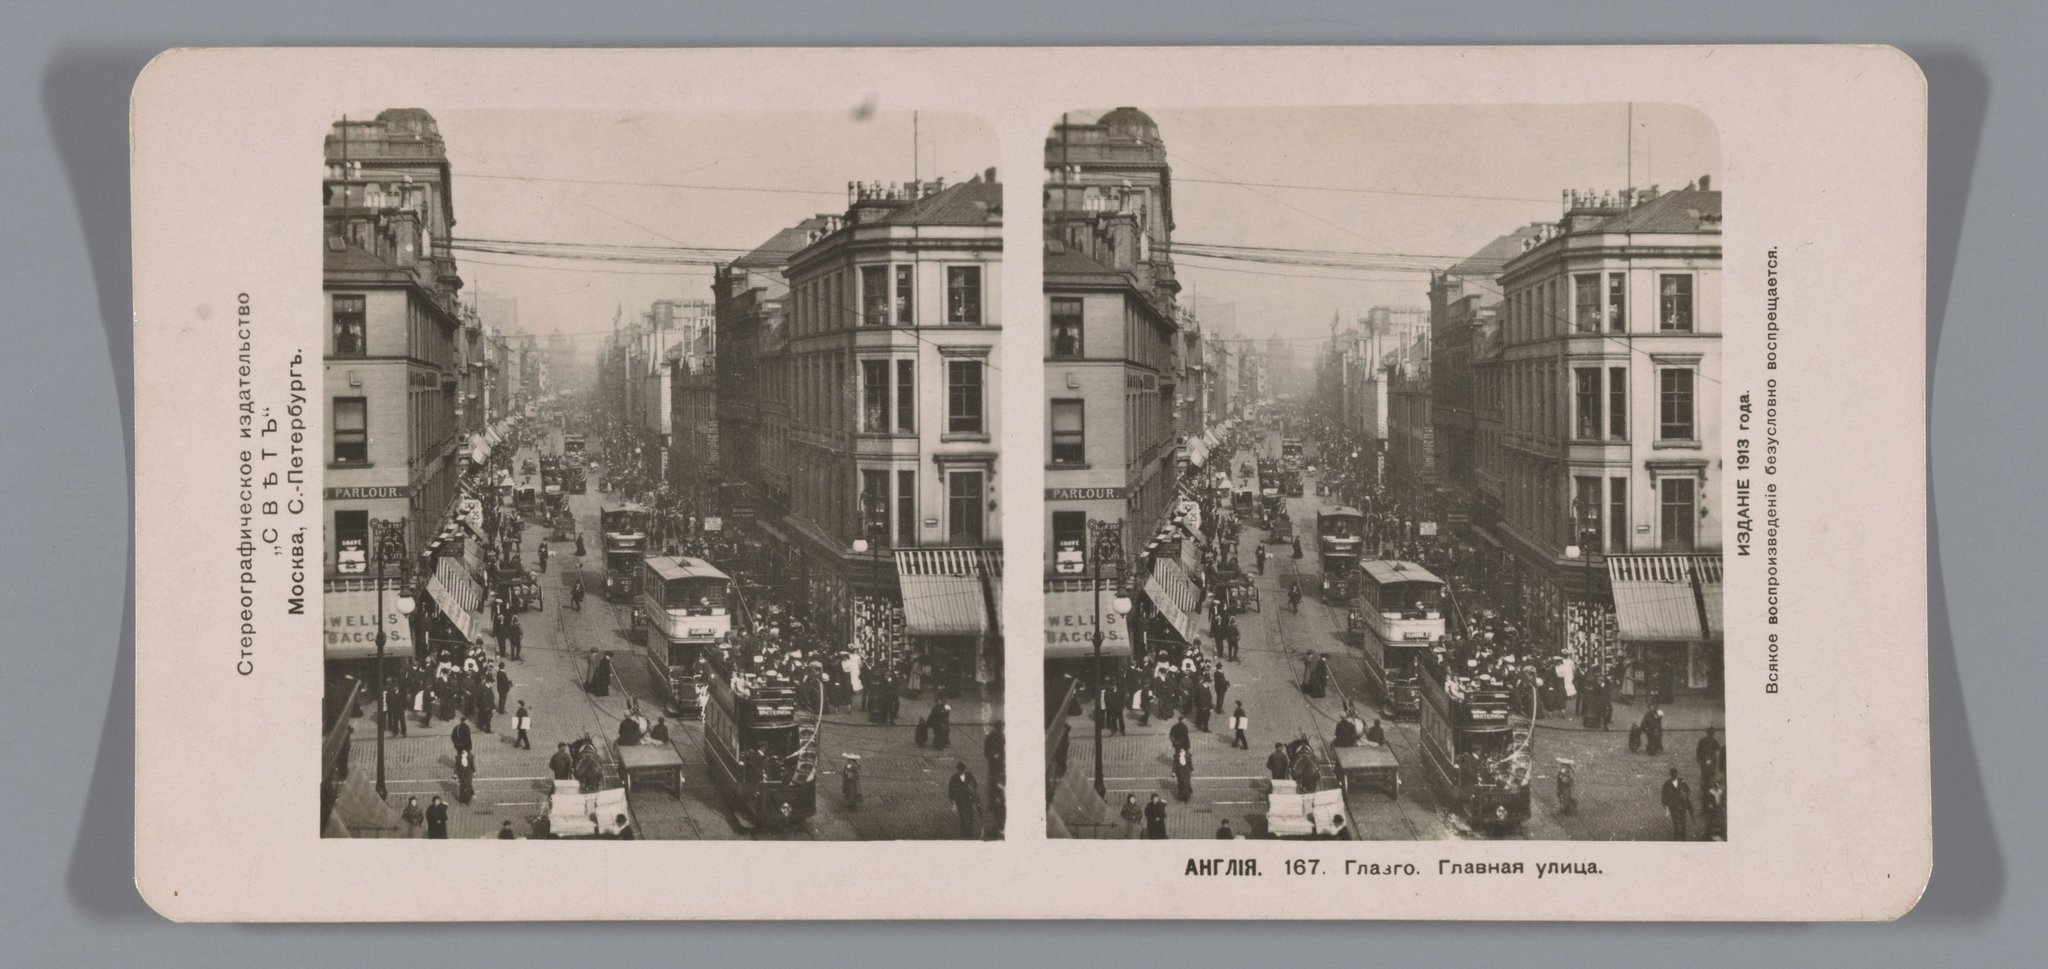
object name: stereograph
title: Gezicht op een straat te Glasgow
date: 1913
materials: cardboard, photographic support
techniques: gelatin silver print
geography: glasgow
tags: street, glasgow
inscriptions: inscription: ‘Izdanie 1913 gora, wsjakoje wosproizwedenije wjezoeslovno wospretsajetsja Moskwa/St Petersburg’, number: ‘167.’